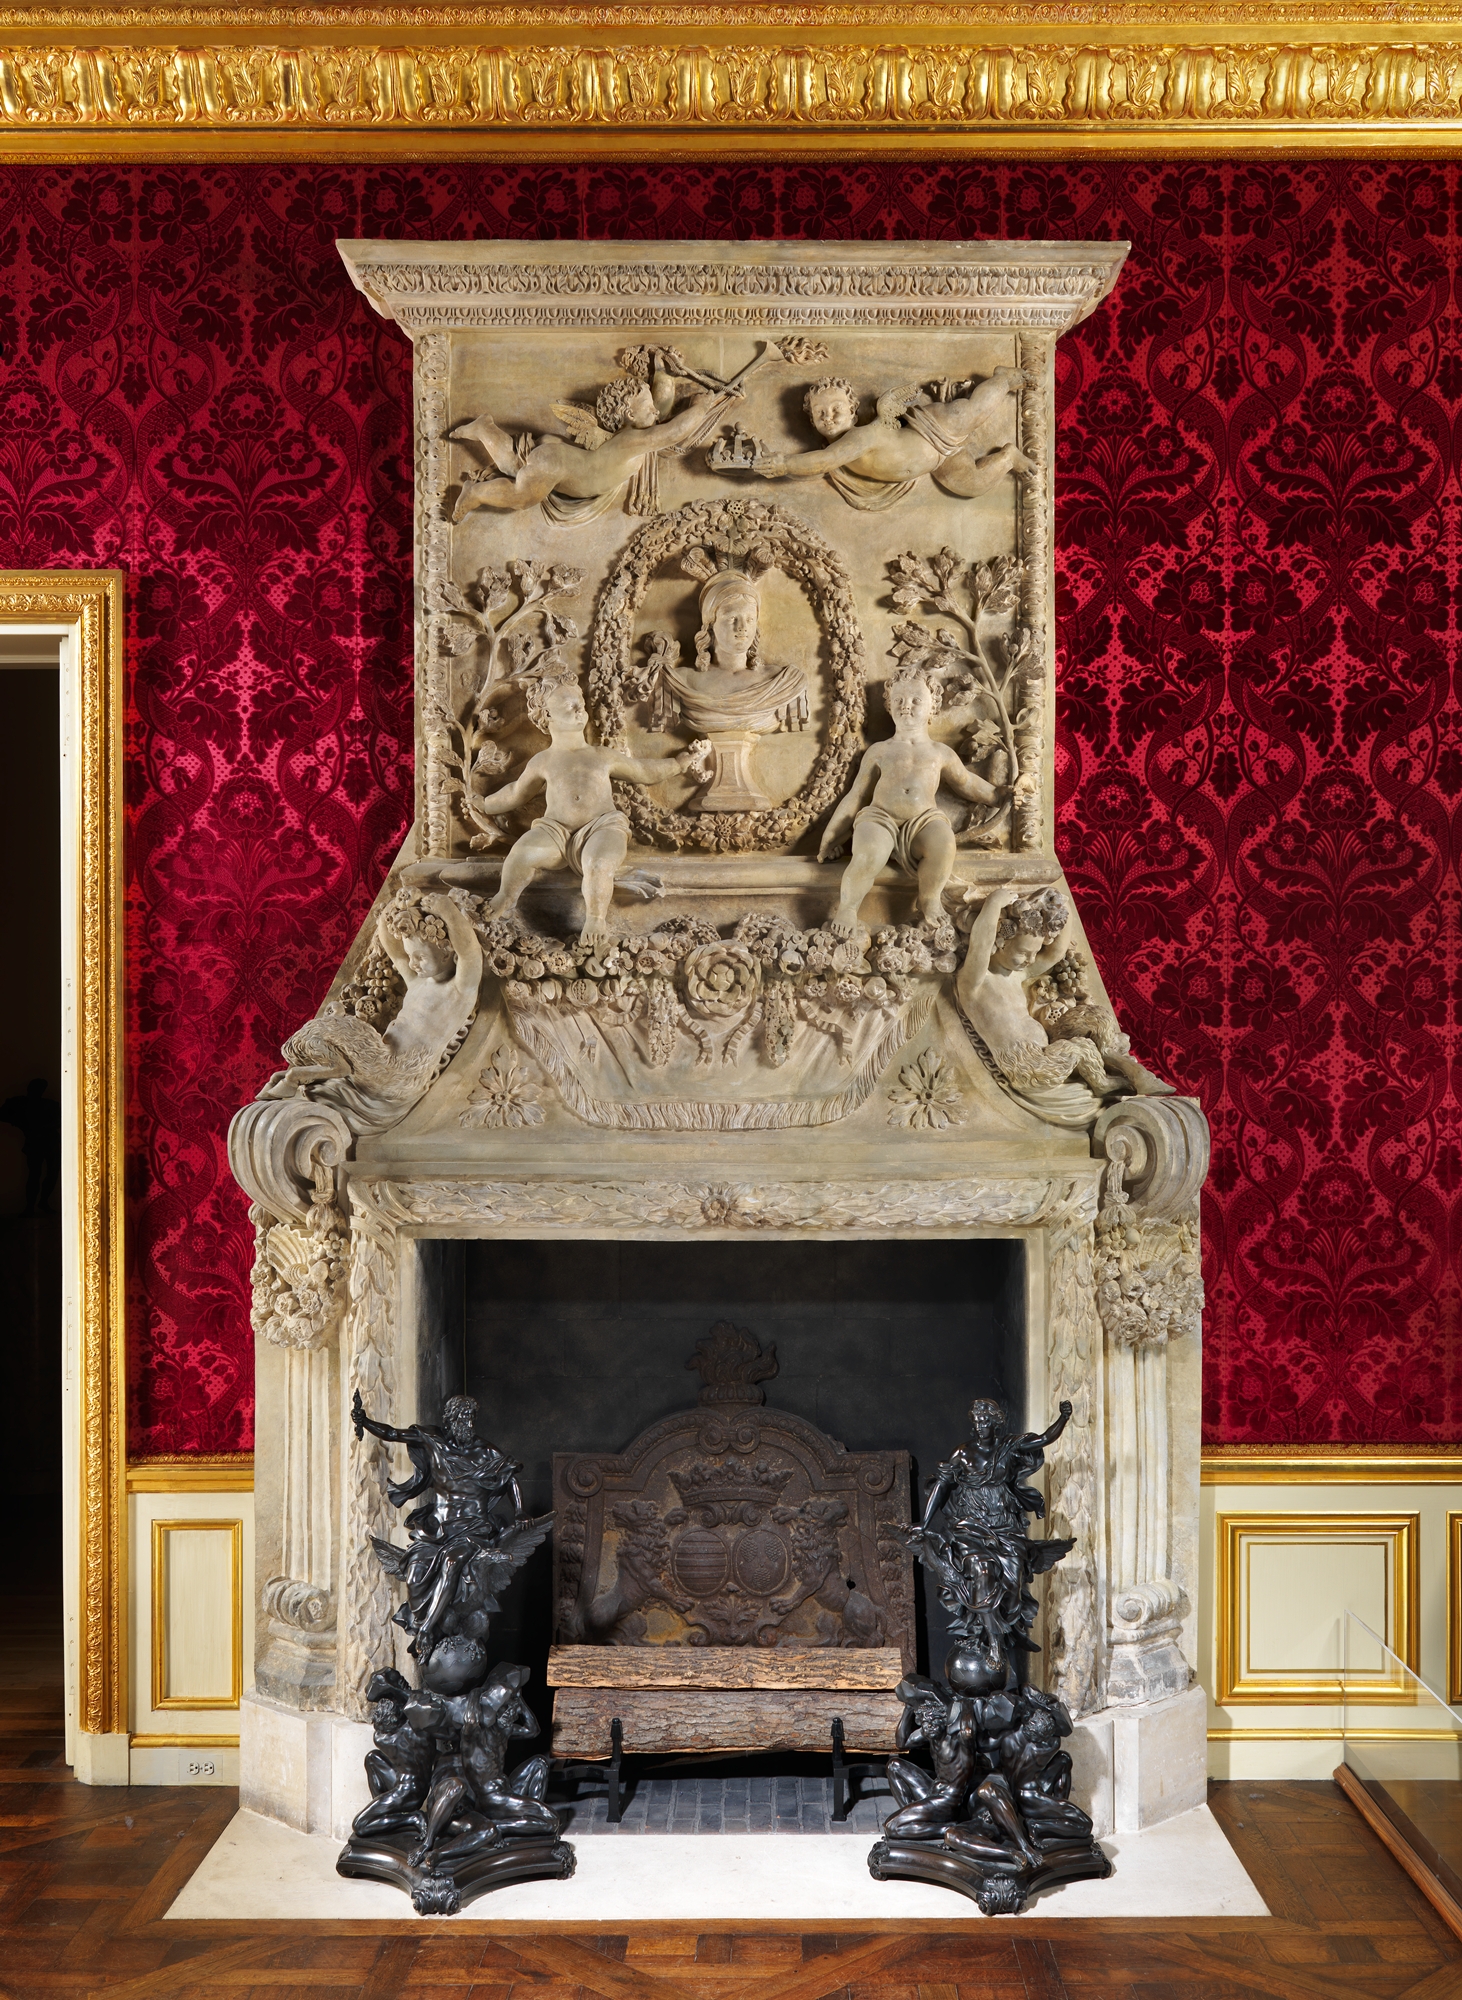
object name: chimneypiece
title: Chimneypiece (cheminée)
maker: jean le pautre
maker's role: artist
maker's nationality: french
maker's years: 1618-1682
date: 1665-1670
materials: limestone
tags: garlands,men,women,putti,satyrs